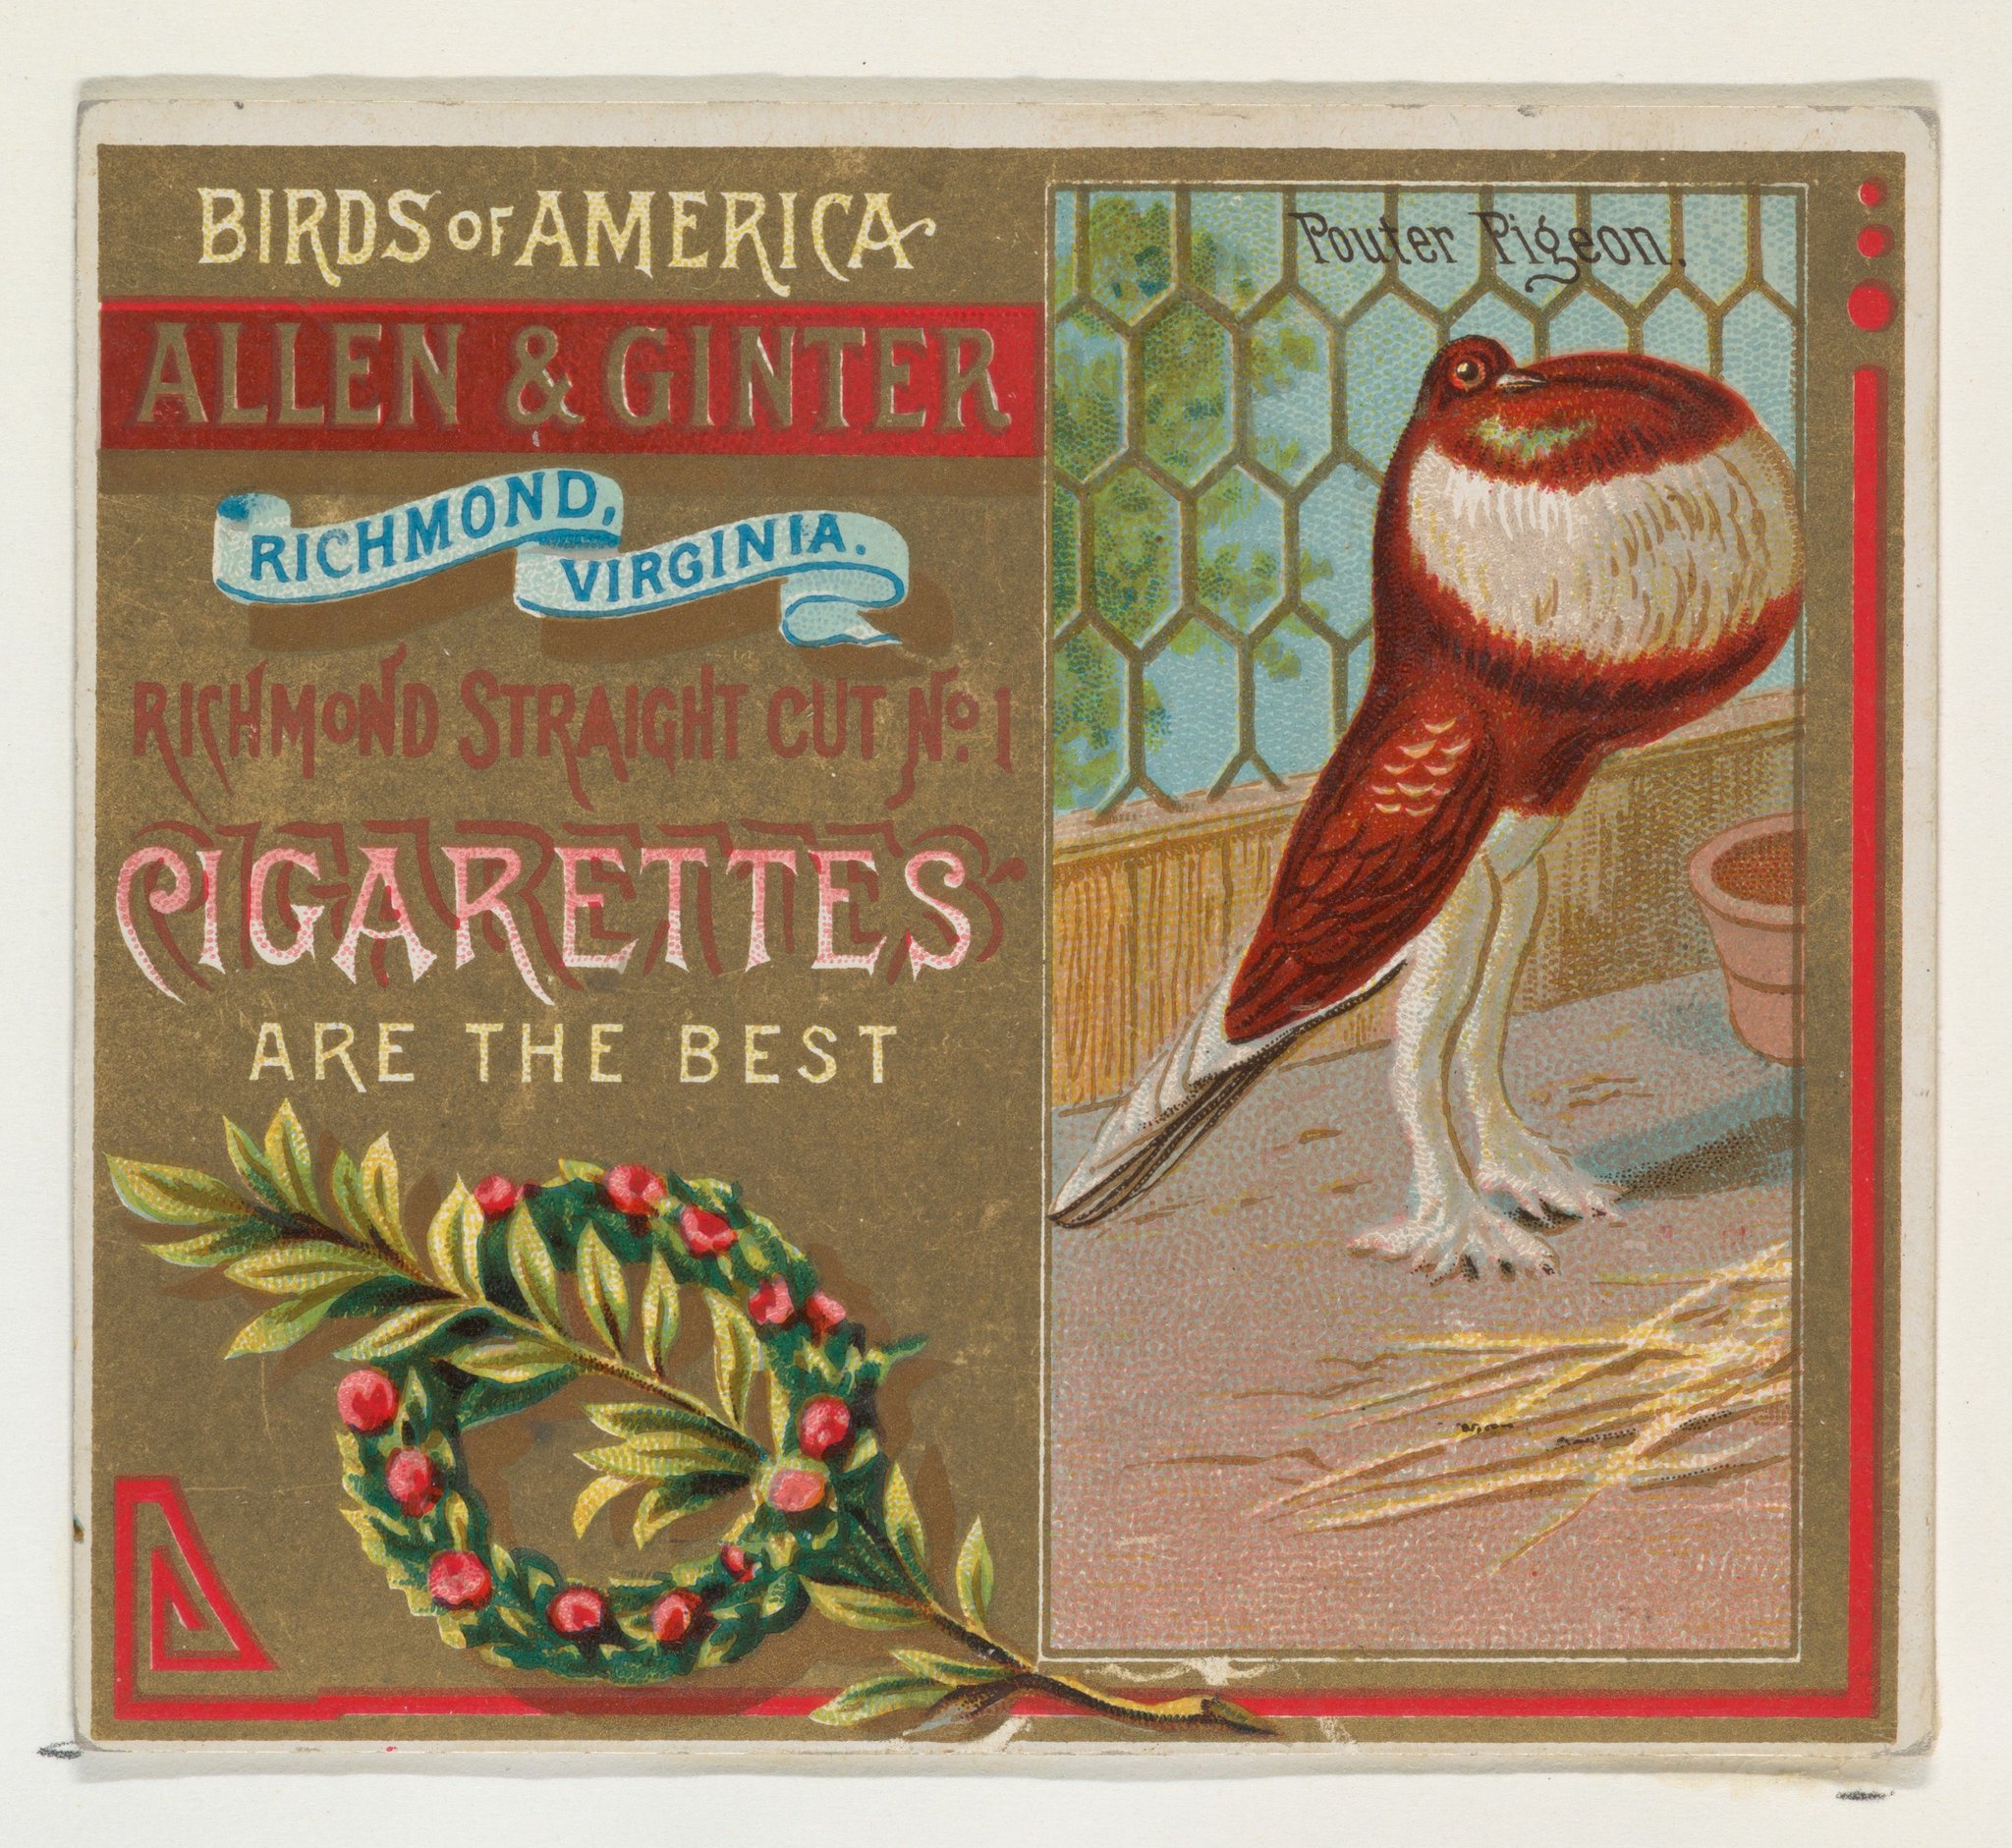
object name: print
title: Pouter Pigeon, from the Birds of America series (N37) for Allen & Ginter Cigarettes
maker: allen & ginter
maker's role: publisher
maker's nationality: american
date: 1888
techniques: color lithograph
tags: birds